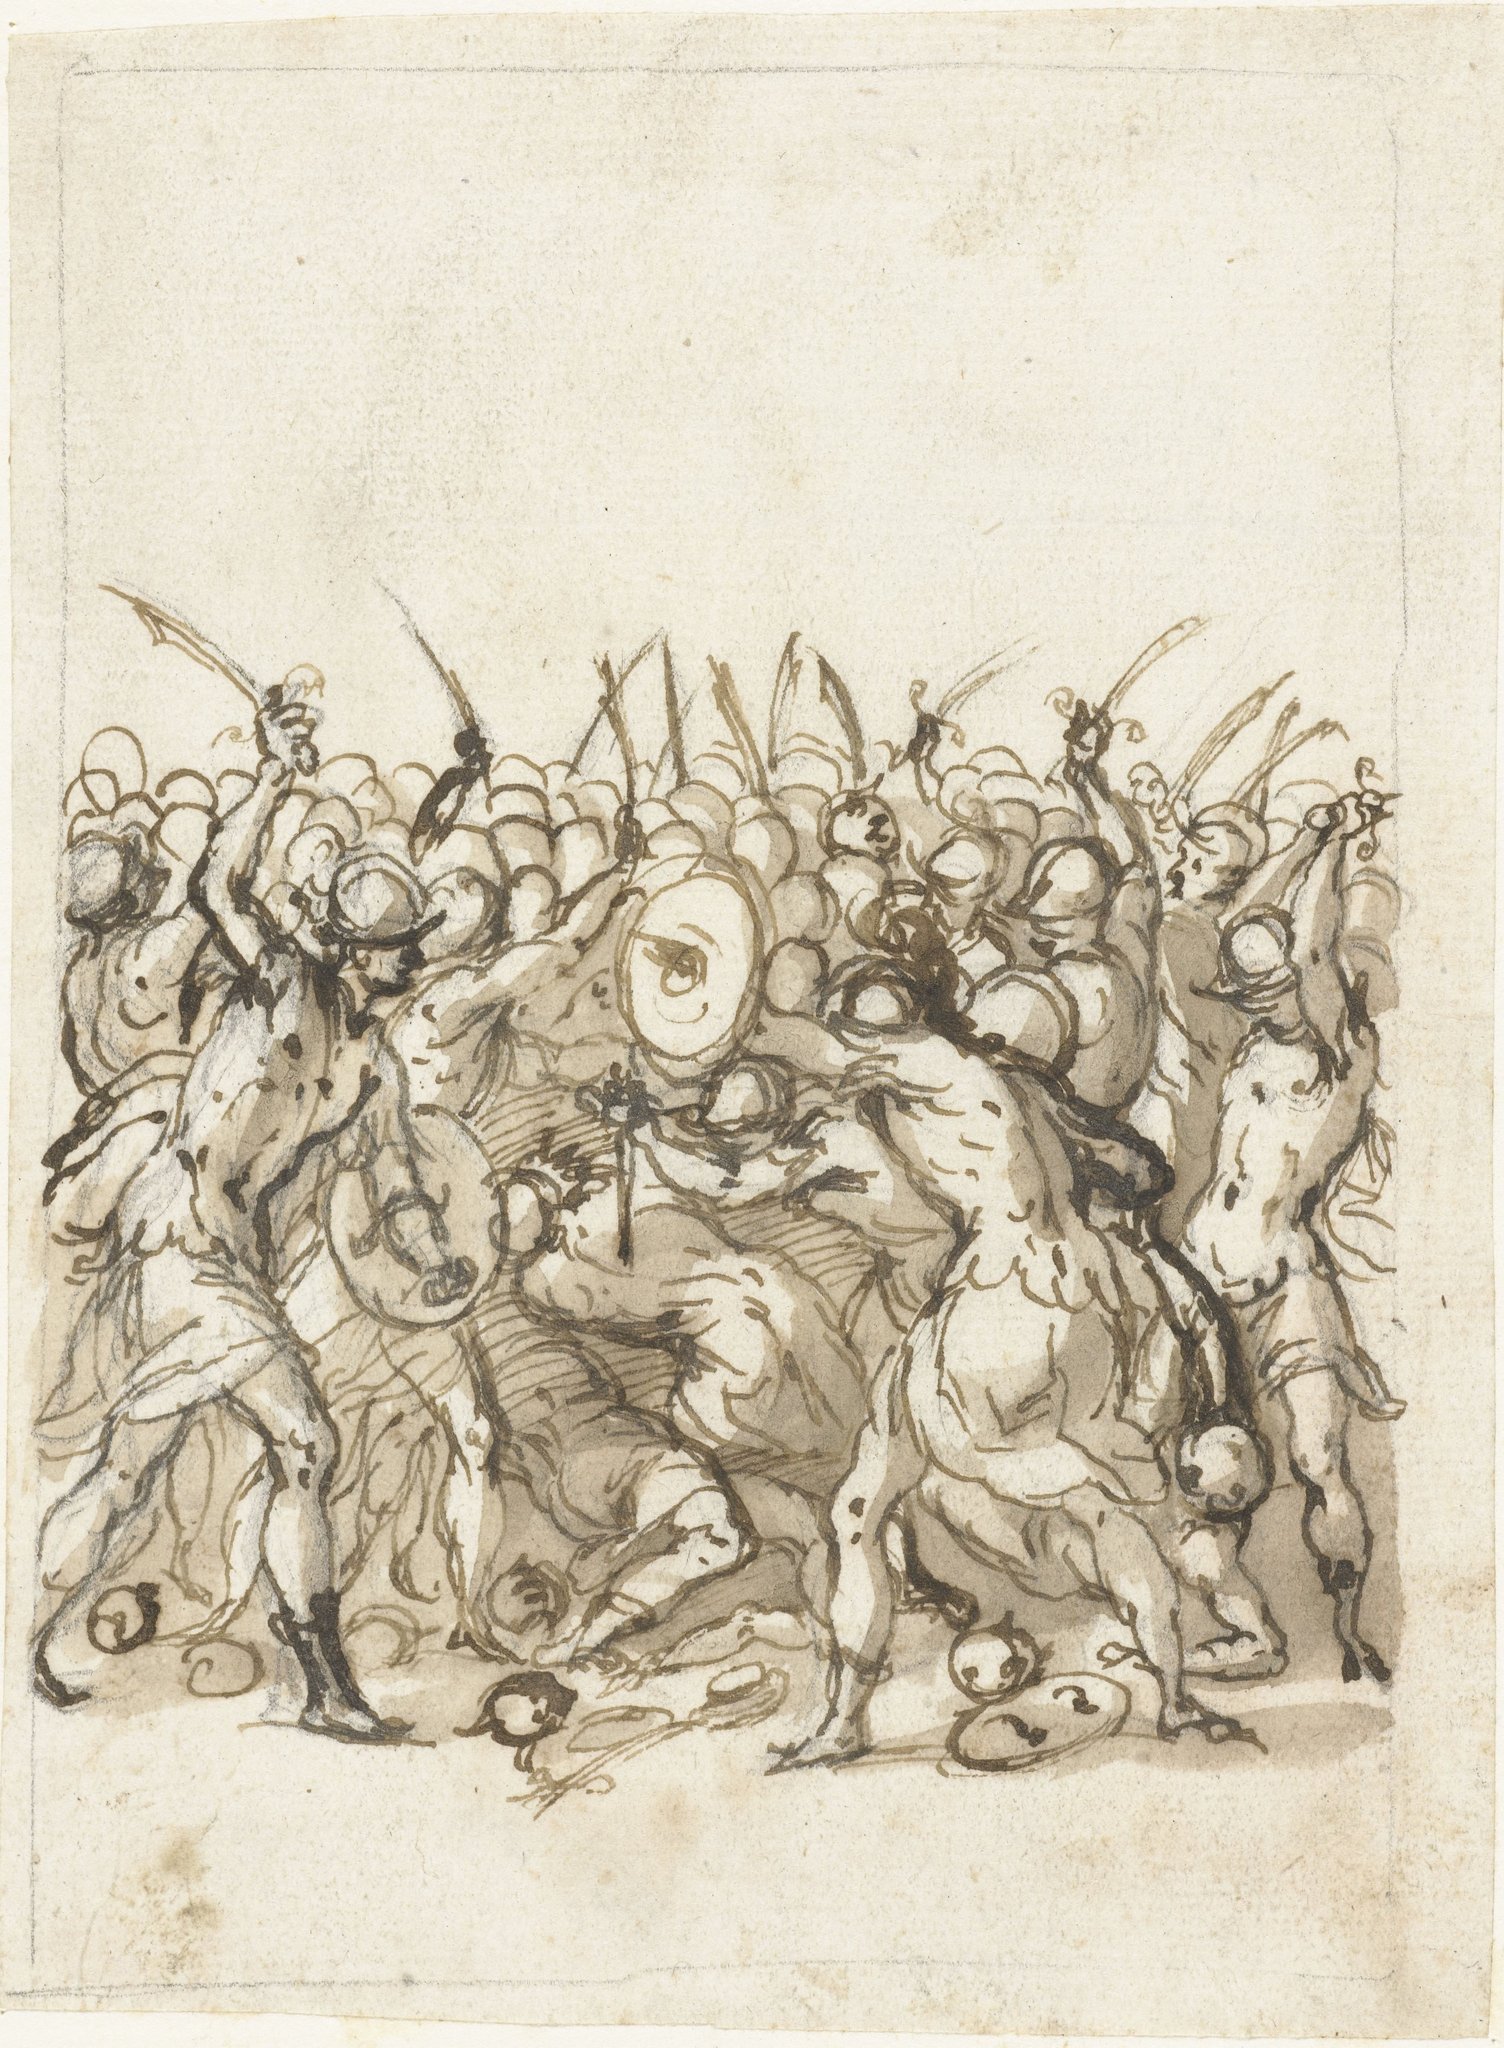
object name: drawing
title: Slag tussen bewapende legers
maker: bernardino india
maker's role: draughtsman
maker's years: 1528-1590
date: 1538-1590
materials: chalk, ink, paper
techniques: brush, pen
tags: battle (+ land forces)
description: Slag tussen met kromzwaarden bewapende legers.